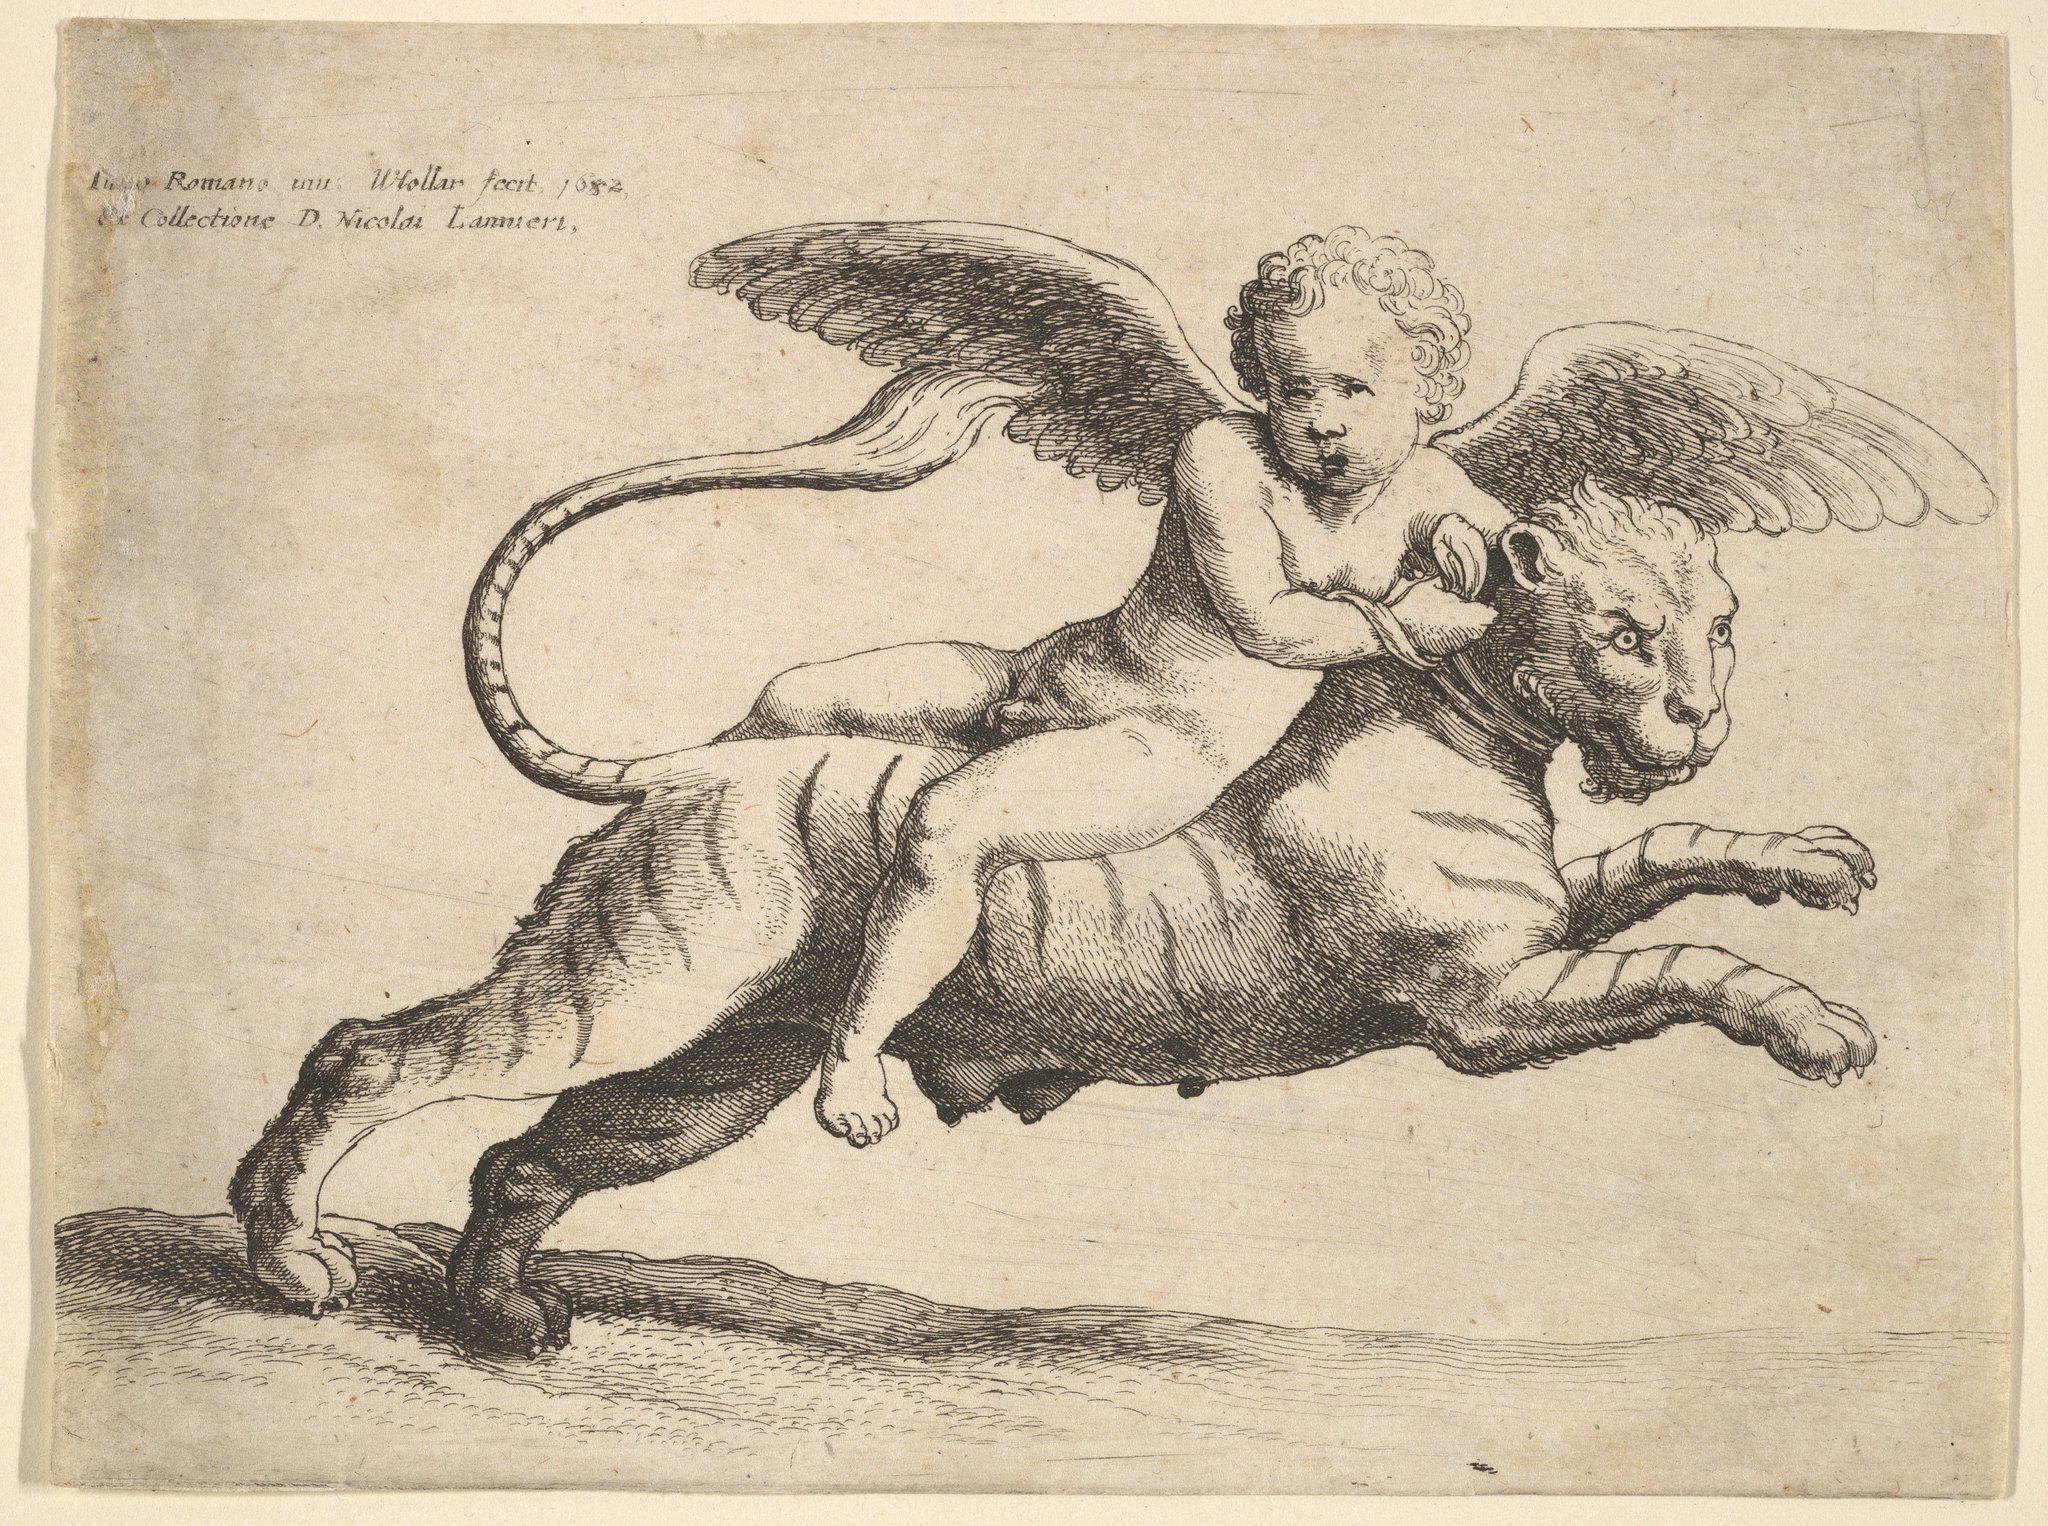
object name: print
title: Cupid on a tiger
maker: wenceslaus hollar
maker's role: artist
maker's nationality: bohemian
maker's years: 1607-1677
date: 1652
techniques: etching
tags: cupid,tigers